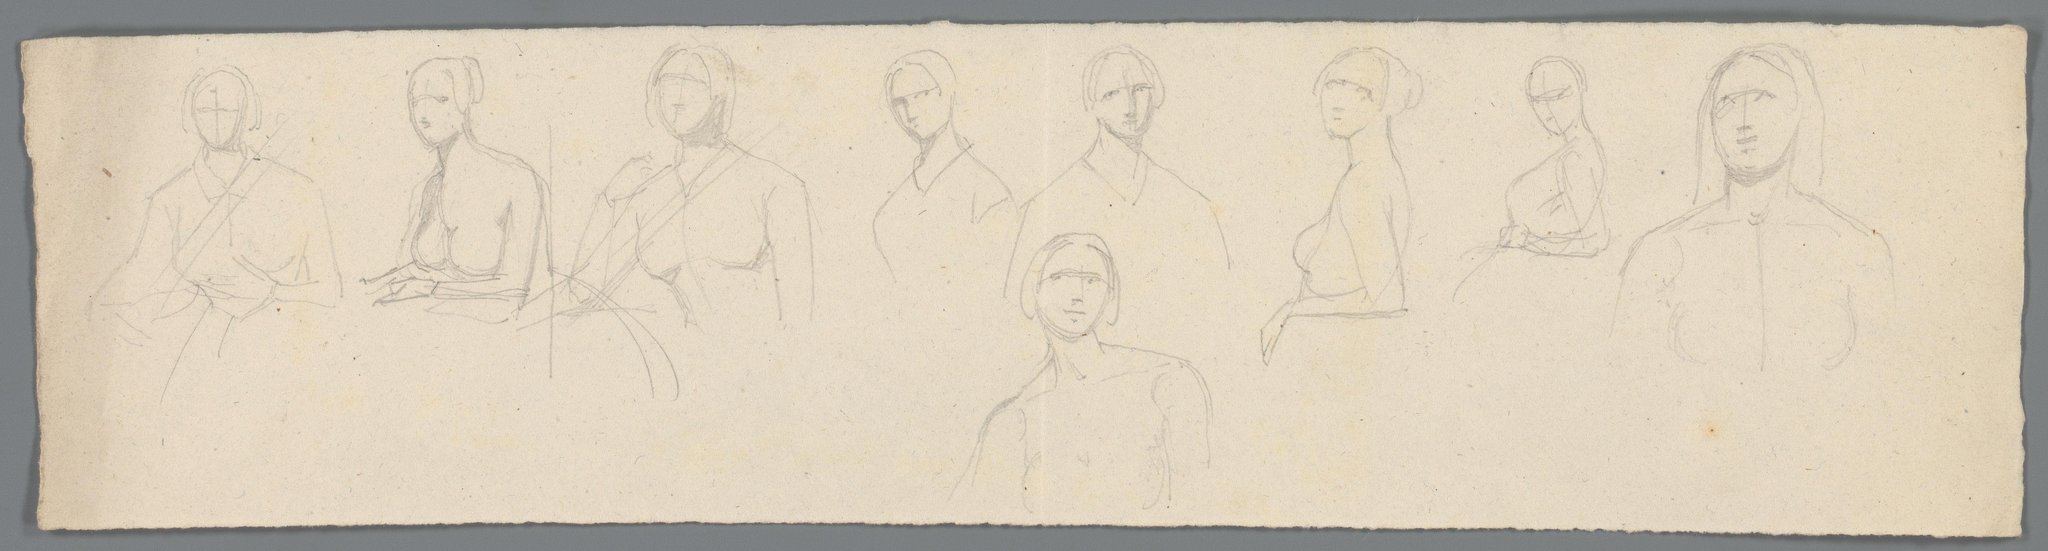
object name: drawing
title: Studies van vrouwen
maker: jacobus everhardus josephus van den berg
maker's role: draughtsman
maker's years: 1802-1861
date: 1812-1861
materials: paper, pencil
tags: the (nude) human figure; 'corpo humano' (ripa) - aa - female human figure